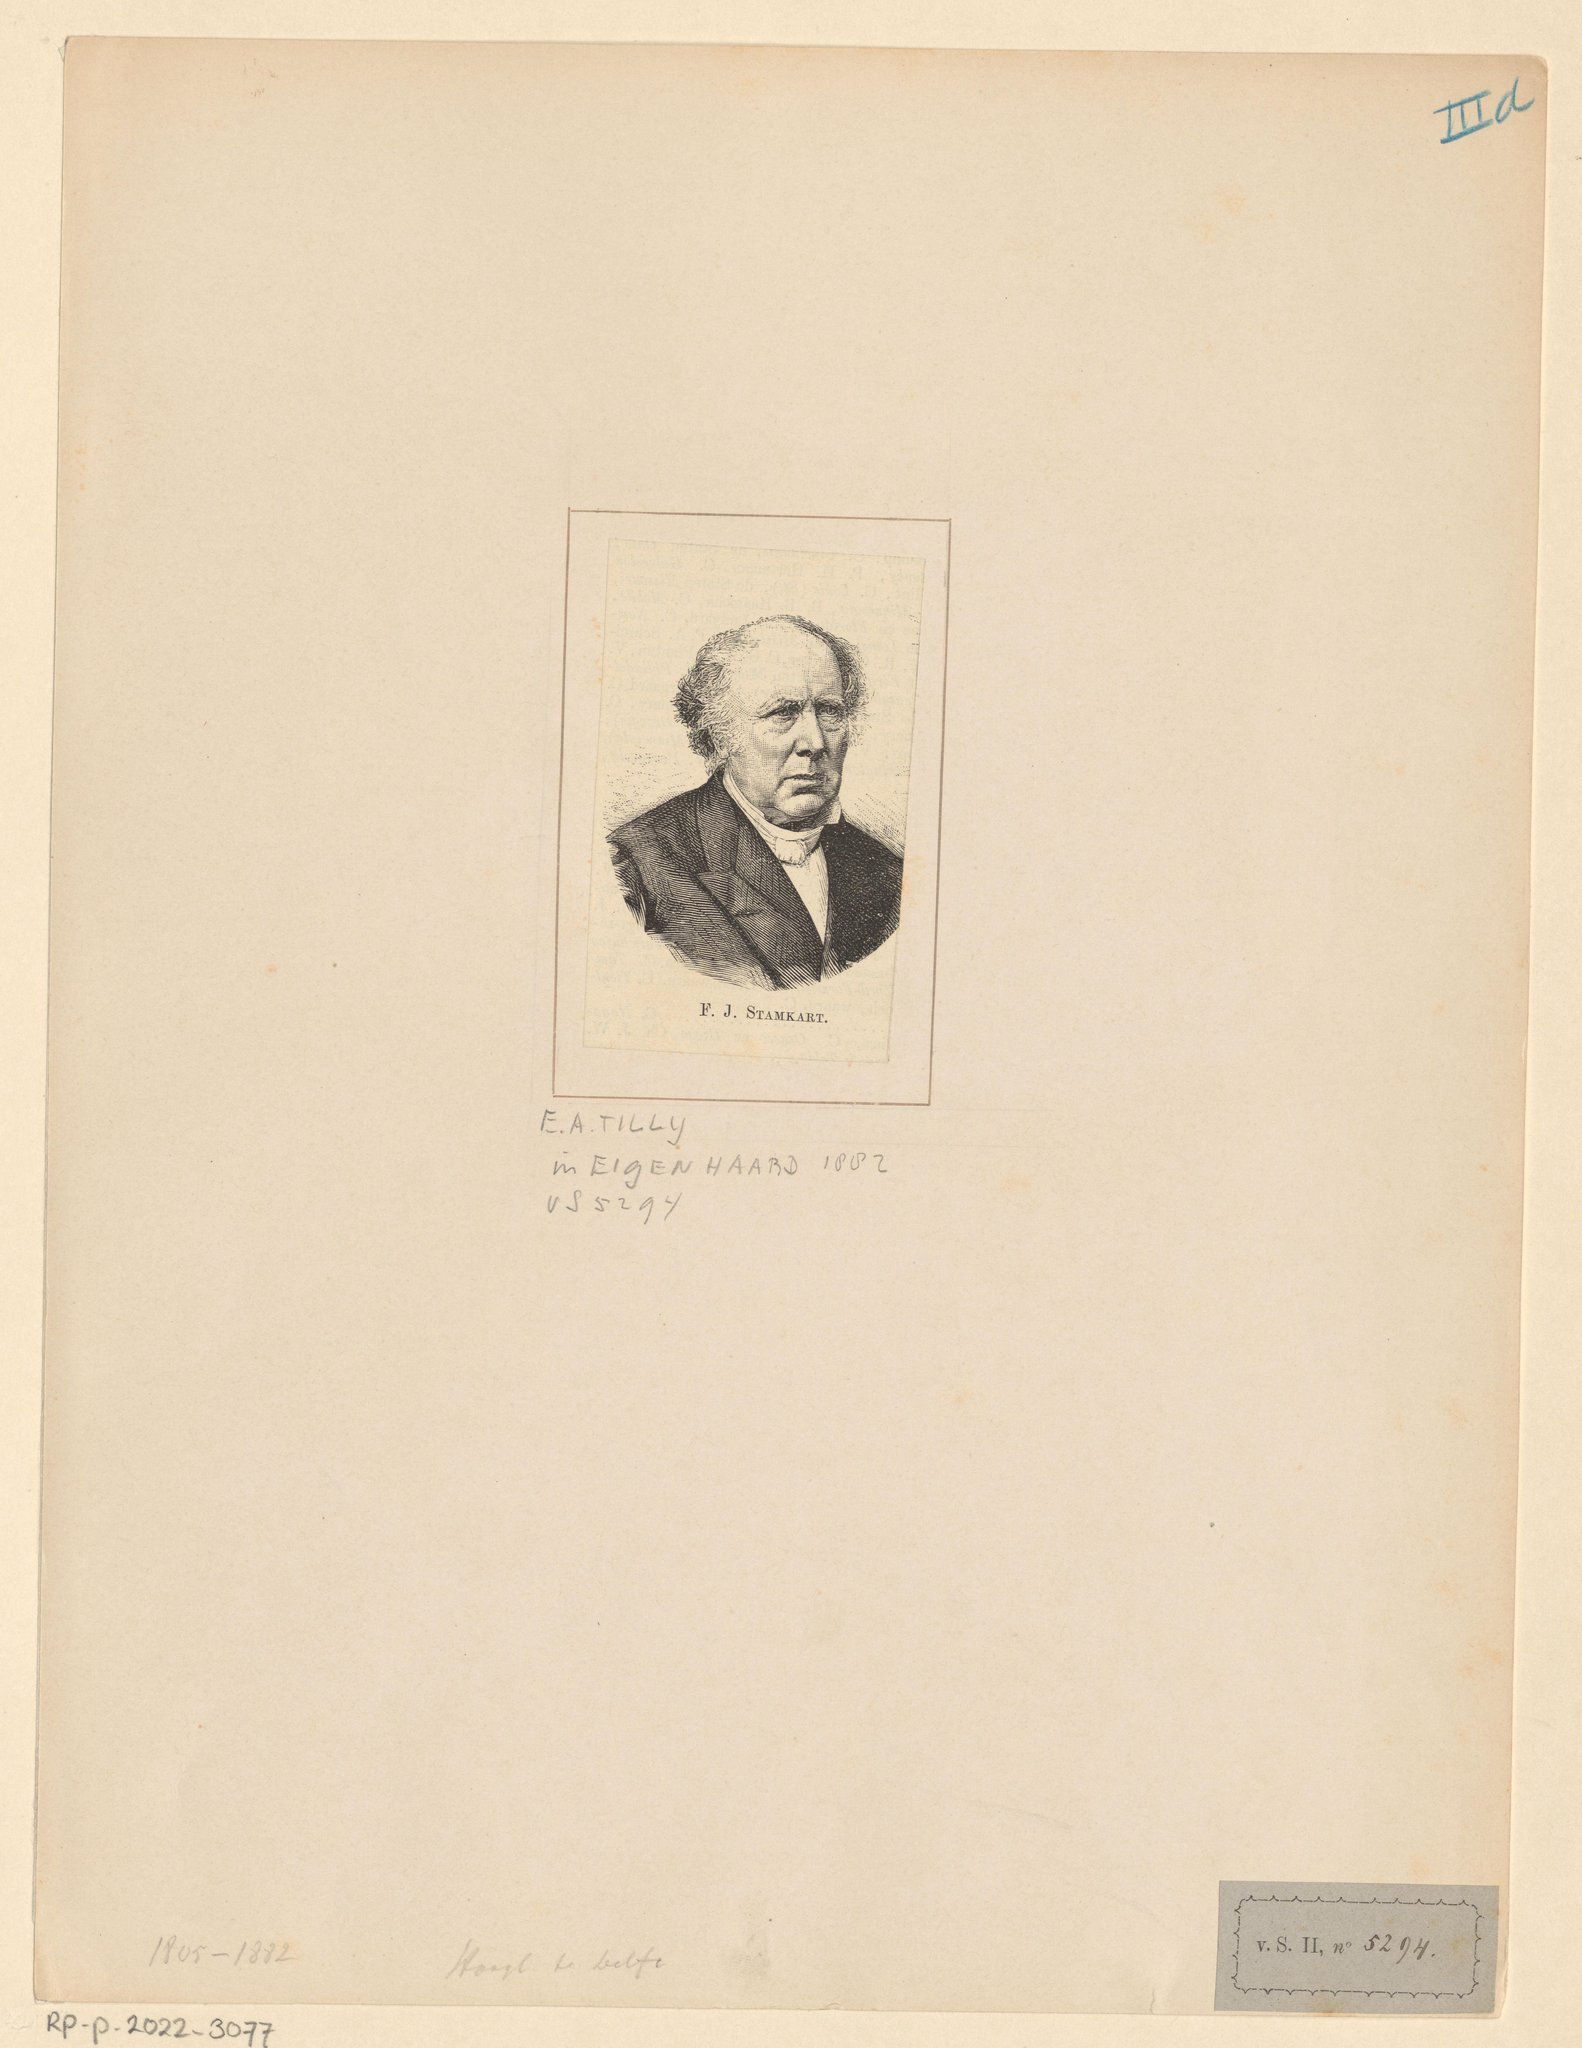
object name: print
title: Portret van Franciscus Johannes Stamkart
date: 1882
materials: ink, paper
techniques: letterpress printing, pen, snipping, engraving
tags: franciscus johannes stamkart, astronomy (and cosmography) (+ portrait of scholar, scientist), historical persons, mathematics (+ portrait of scholar, scientist)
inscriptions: : ‘v.S. II, no 5294.’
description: Prent mogelijk uit: Eigen Haard (1882), 1882.